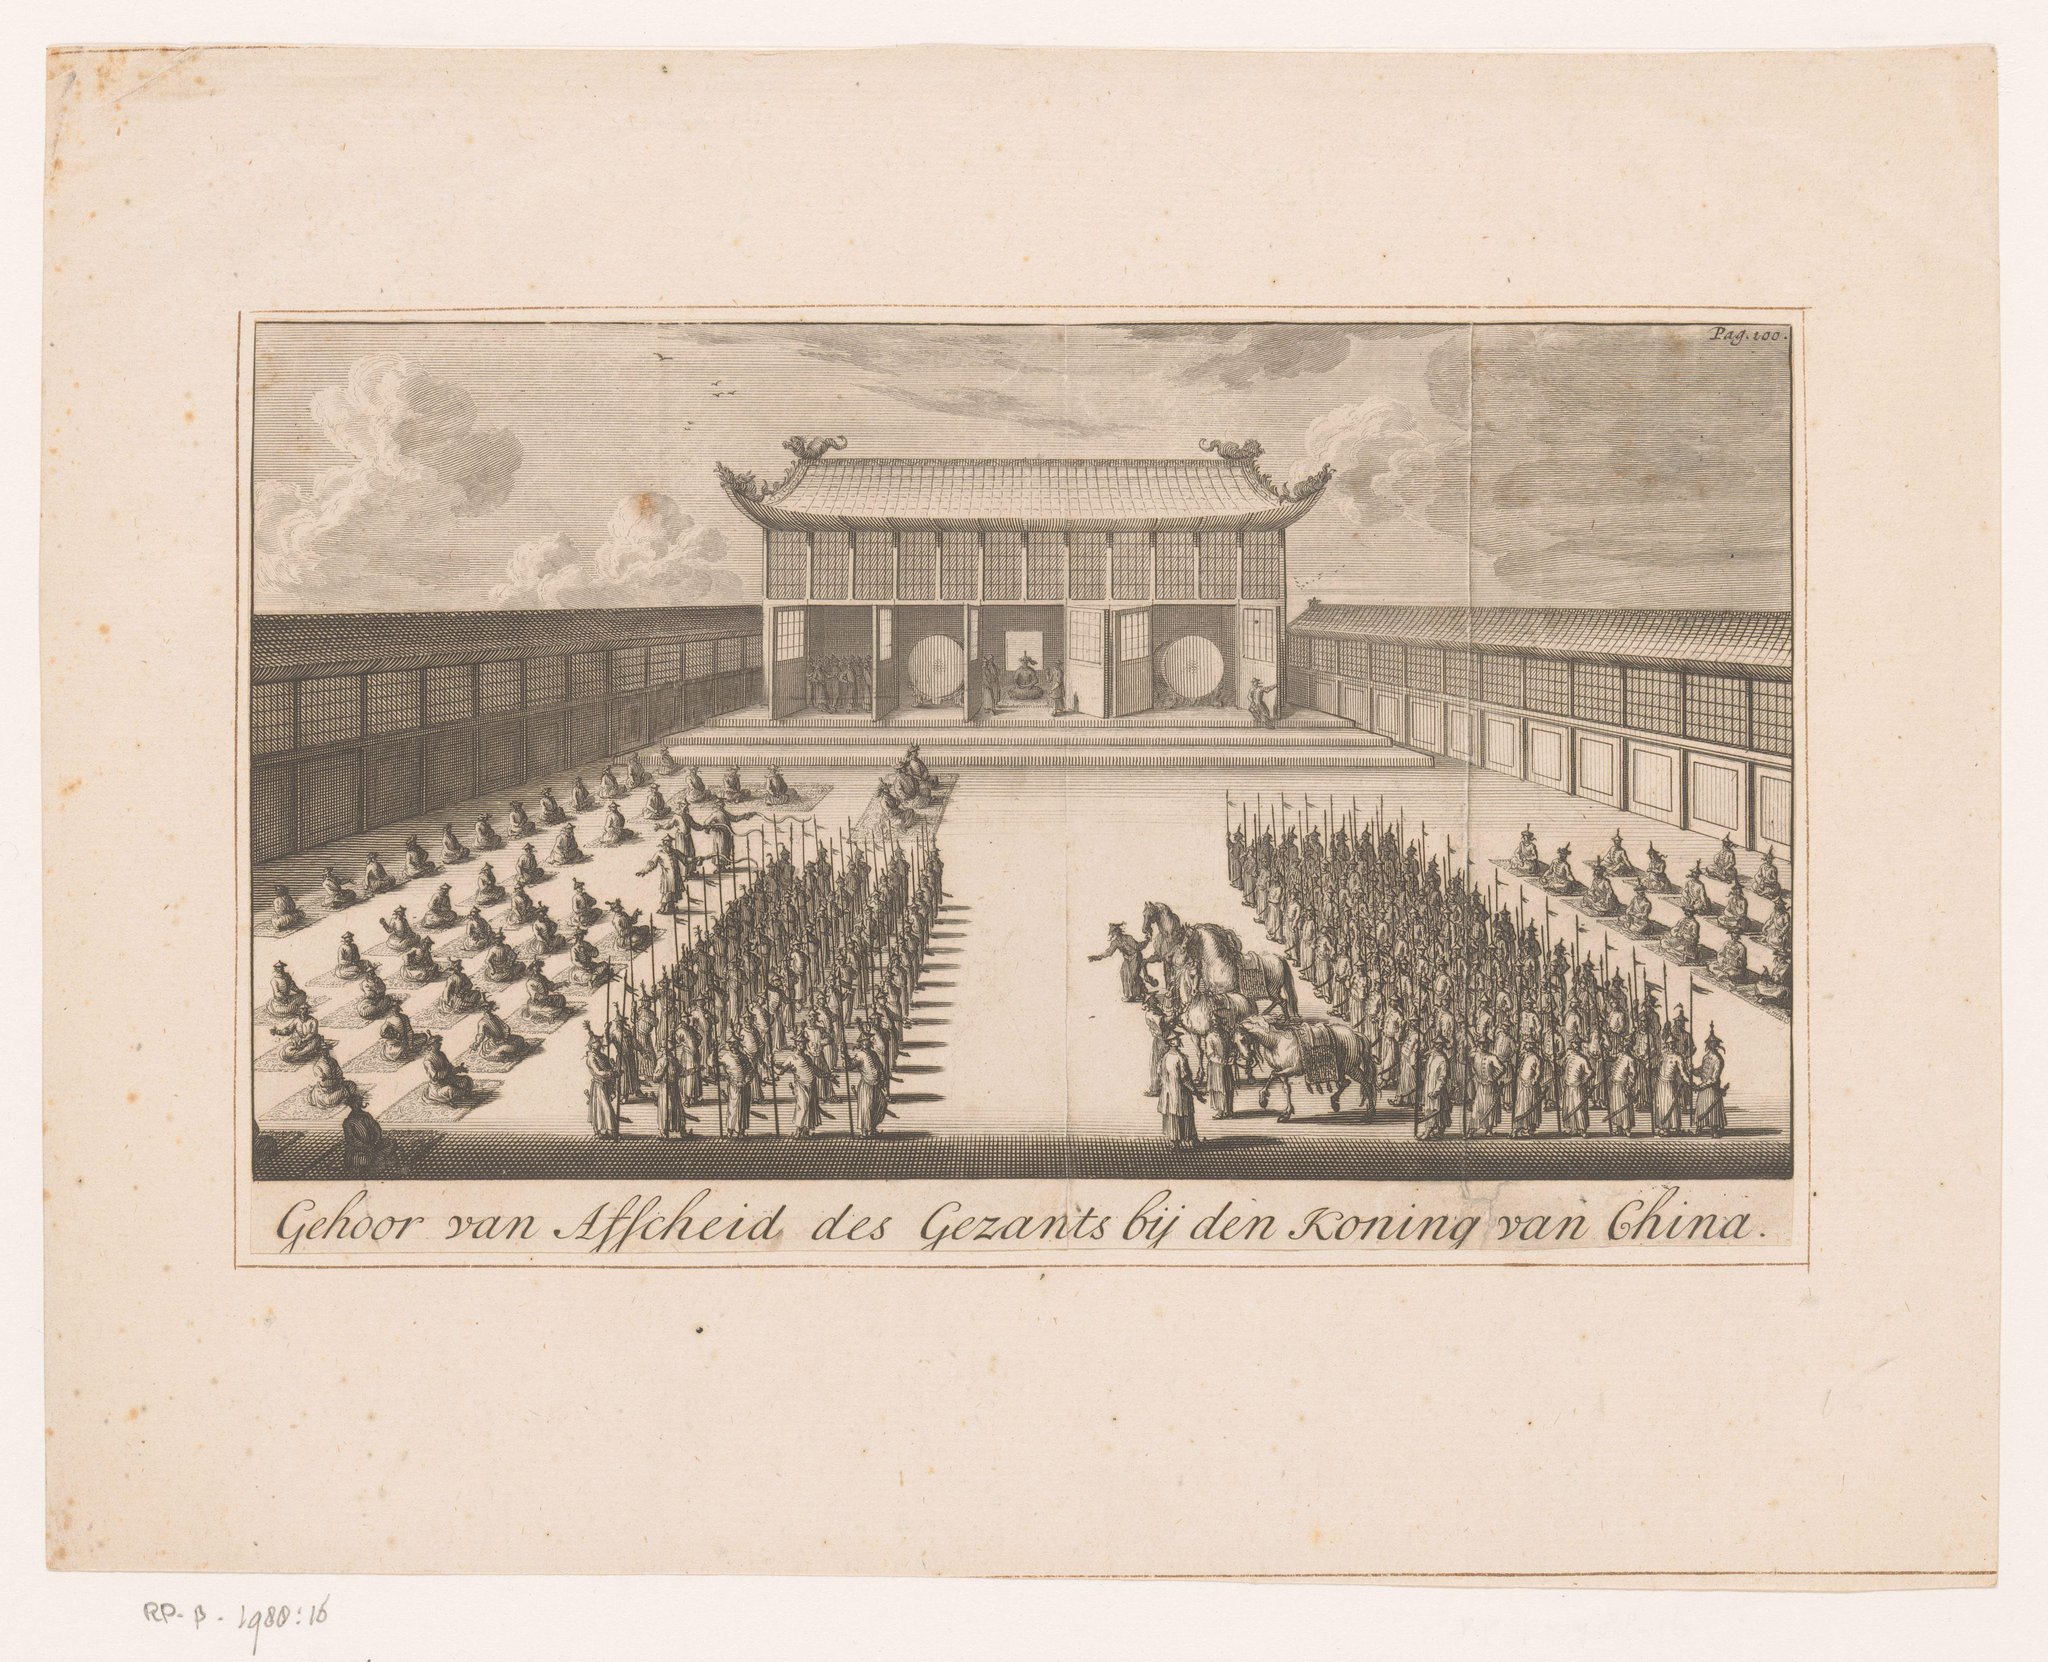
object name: book illustration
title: Gehoor van afscheid des Gezants bij den Koning van China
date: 1710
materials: paper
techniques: engraving, etching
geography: amsterdam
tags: guard of honour, reception ~ ambassador, china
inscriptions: collector's mark: Lugt 2228, collector's mark: Lugt 2760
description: Op een binnenplein staat de lijfwacht van de koning in opstelling om de Deense afgezant Eberhard Isbrand Ides te ontvangen. Achteraan zit de koning in een gebouw met grote openstaande deuren, een groep muzikanten en twee grote trommels.